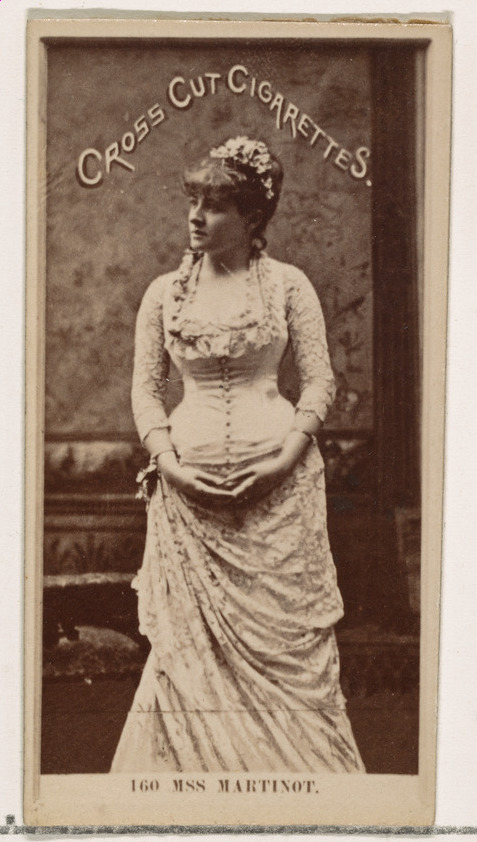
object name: print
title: Card Number 160, Miss Sadie Martinot, from the Actors and Actresses series (N145-2) issued by Duke Sons & Co. to promote Cross Cut Cigarettes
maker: w. duke, sons & co.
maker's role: publisher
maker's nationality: american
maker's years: 1870-1920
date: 1880-1889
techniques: albumen silver print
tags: portraits,women,actresses